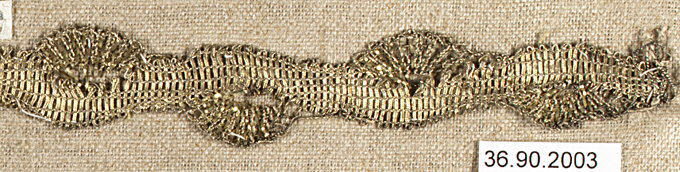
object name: piece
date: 1701-1800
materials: metal thread, silk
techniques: lace